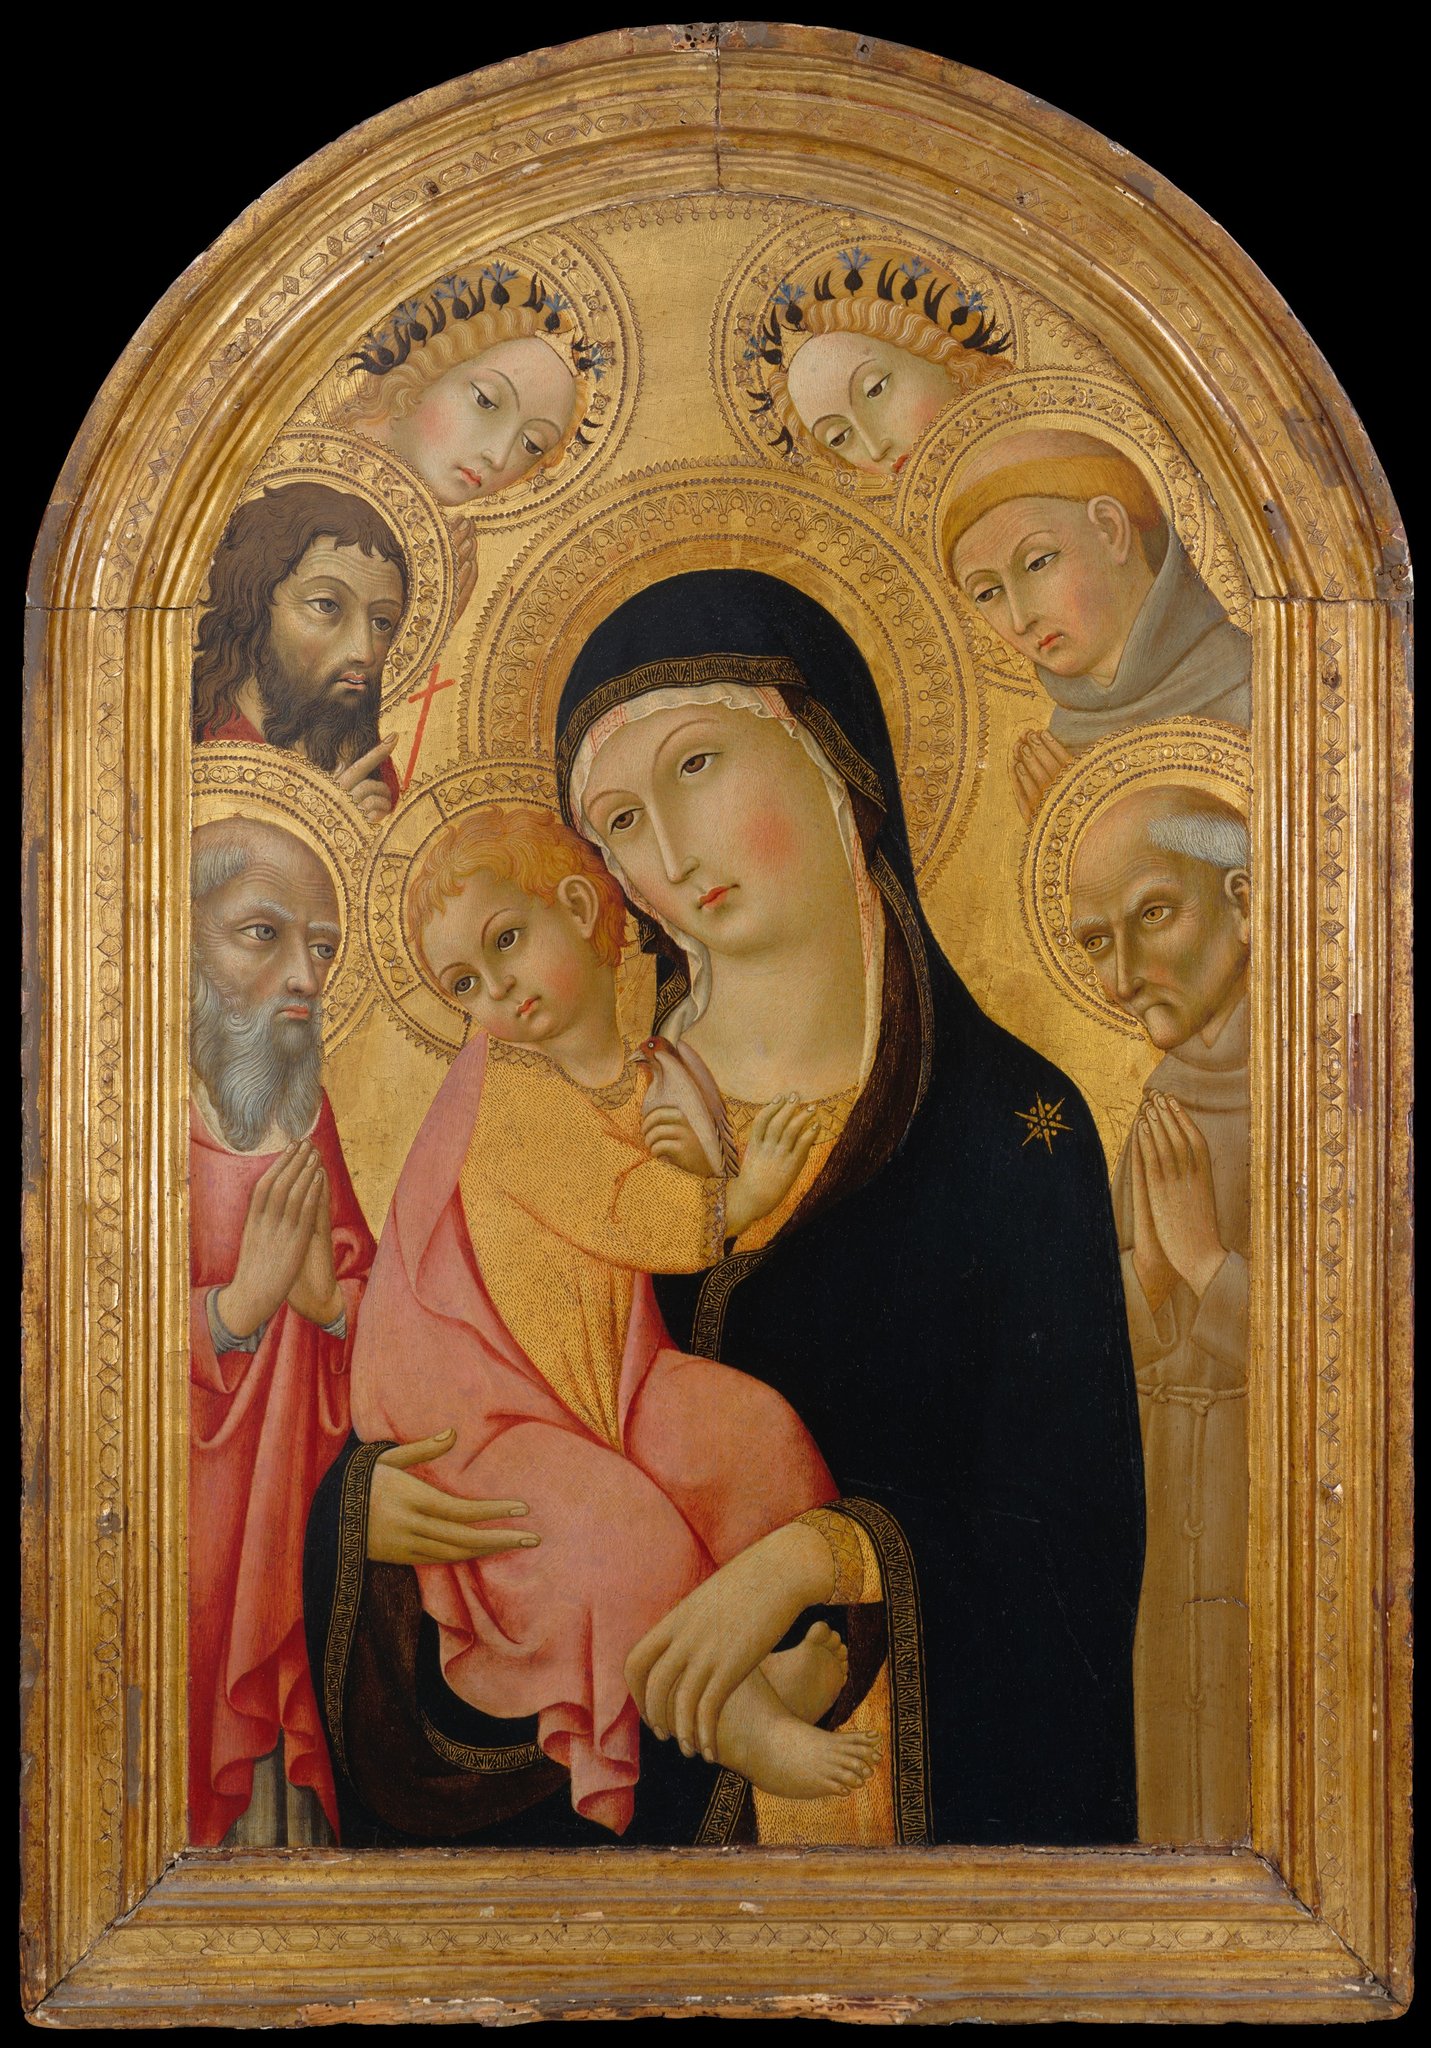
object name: painting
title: Madonna and Child with Saints Jerome, Bernardino, John the Baptist, and Anthony of Padua and Two Angels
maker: sano di pietro (ansano di pietro di mencio)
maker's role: artist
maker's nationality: italian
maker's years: 1405-1481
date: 1465-1470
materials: gold leaf, paint, wood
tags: angels,madonna and child,saint jerome,saint john the baptist